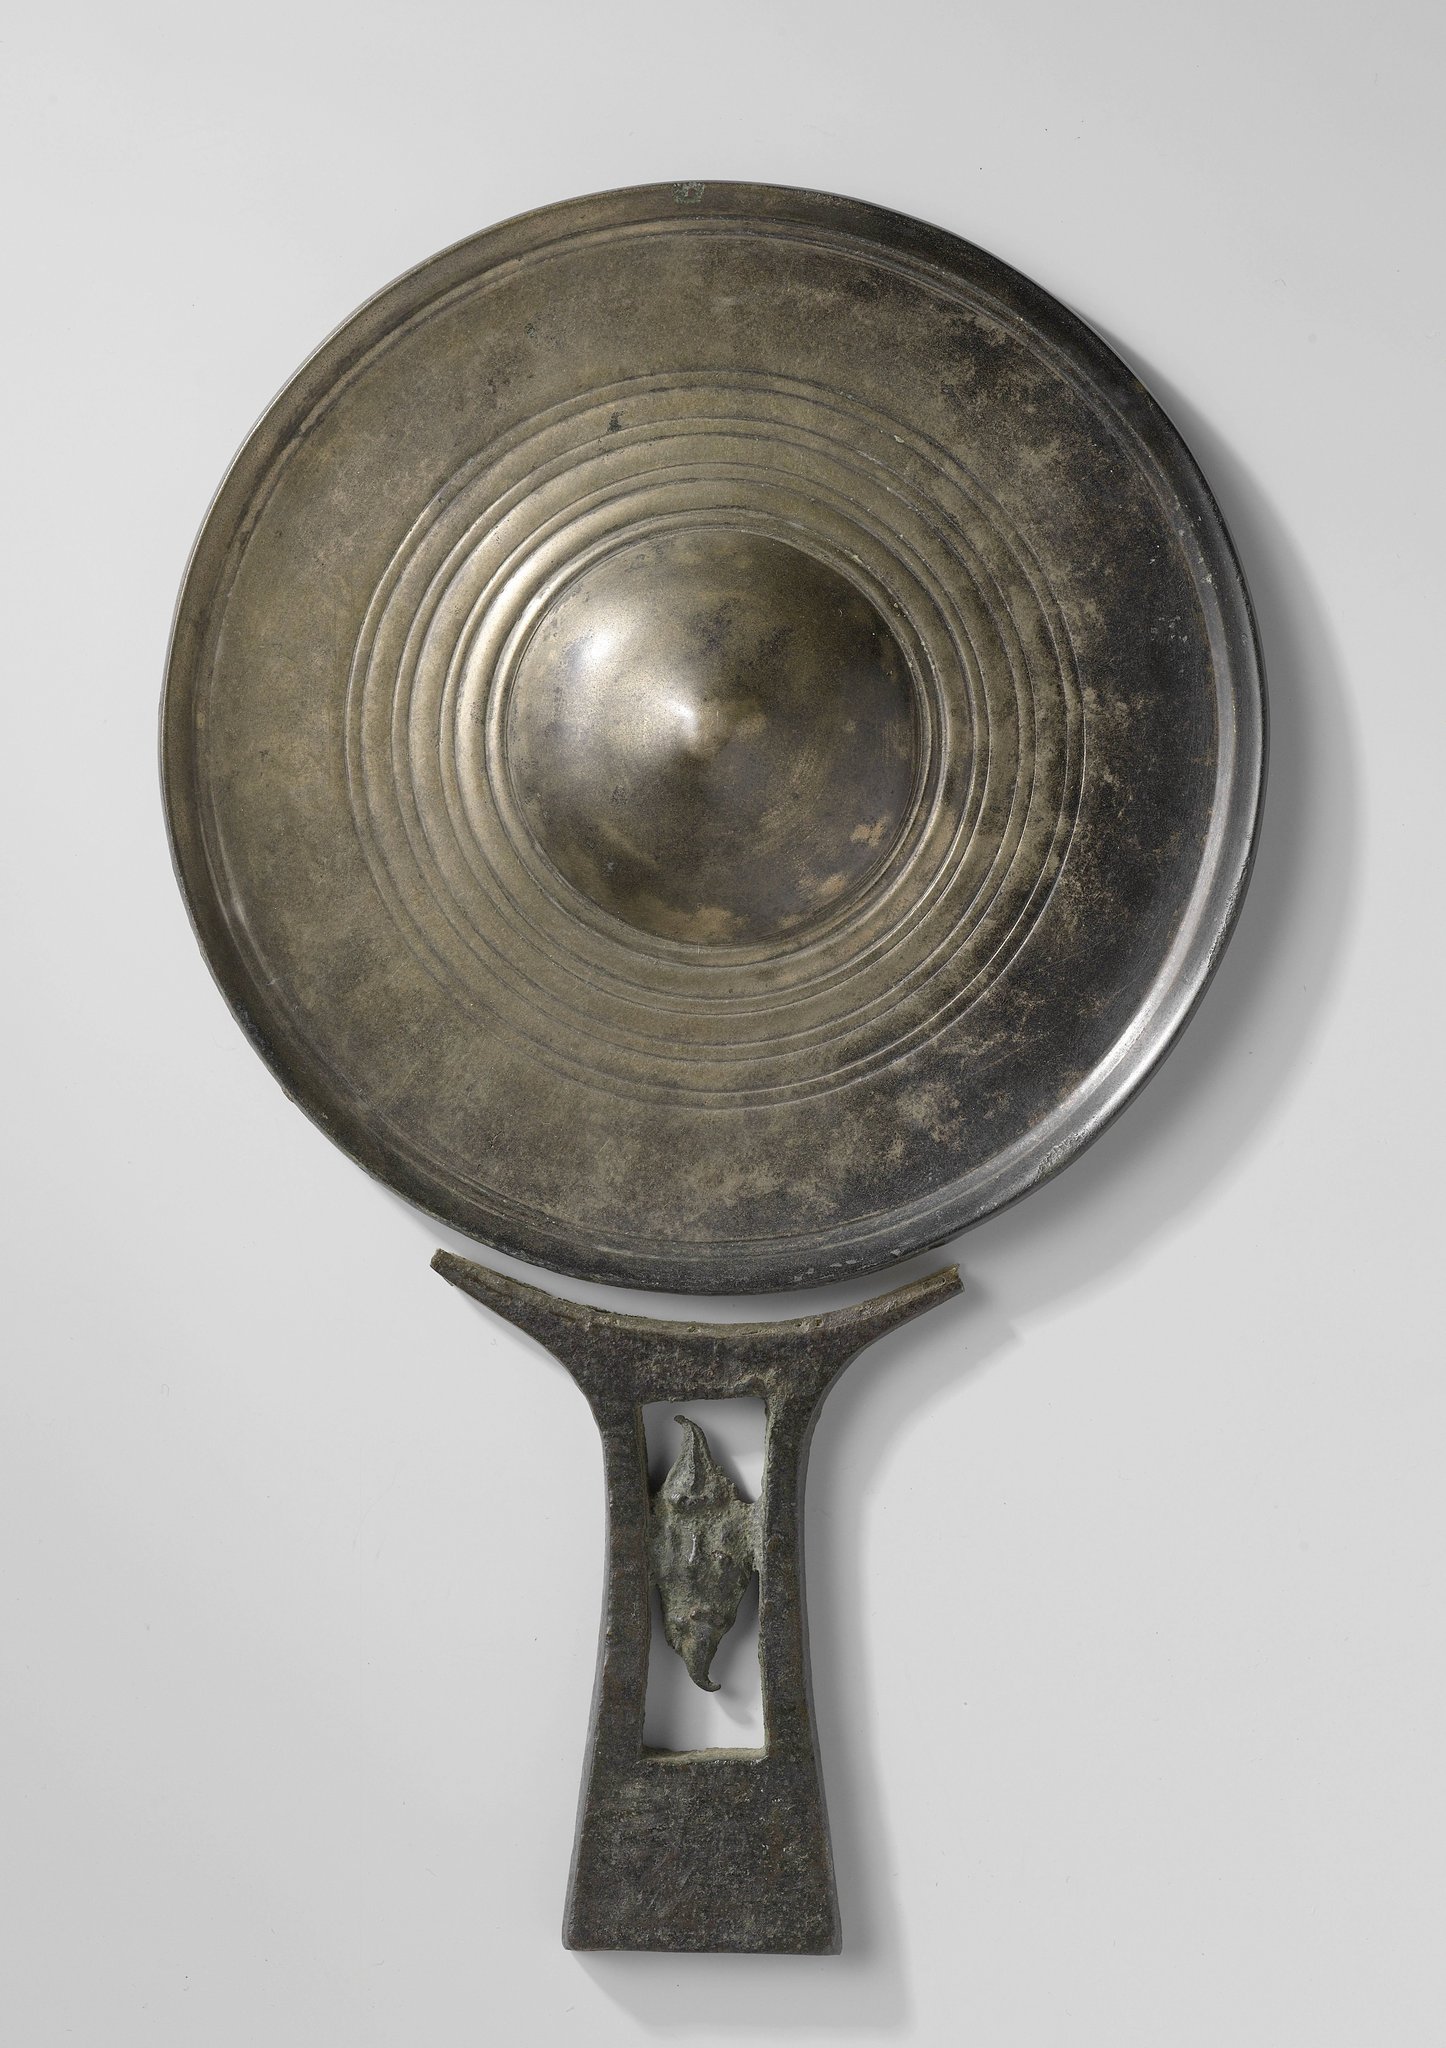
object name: mirror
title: Spiegel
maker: Anonymous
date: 1300-1600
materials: bronze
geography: indonesia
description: Spiegel: in centrum borstvormige uitstulping omringd door vier, dubbele concentrische cirkels. Het handvat is plat met opengewerkt langwerpig siermotief in lengterichting.